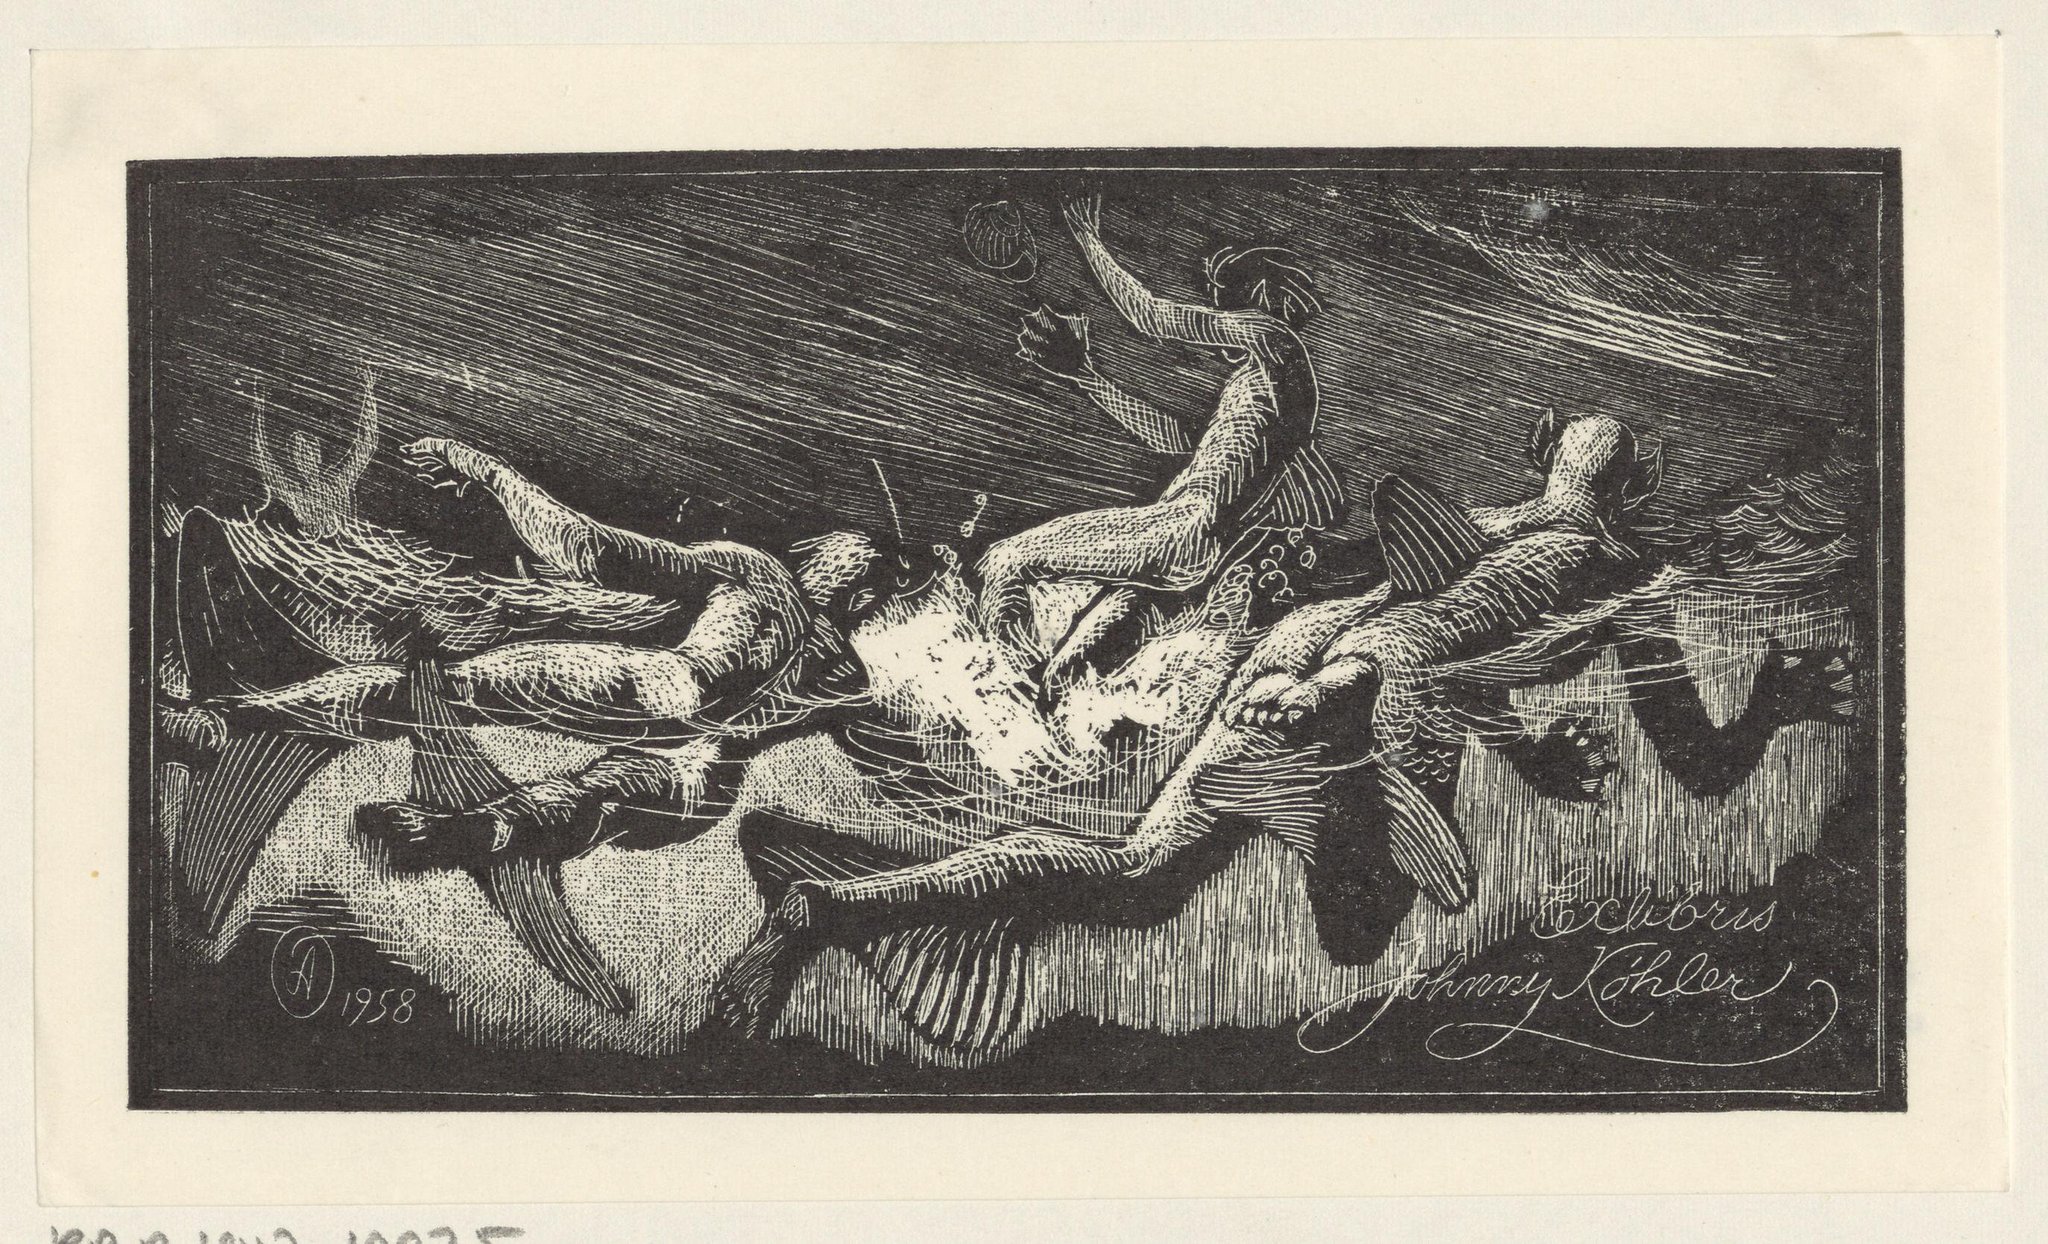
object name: bookplate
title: Ex libris van Johnny Køhler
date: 1958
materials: paper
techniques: printing block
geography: denmark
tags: fishes, swimming (movement in water), man (showing himself) undressed, quasi-nude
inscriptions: workshop stamp: ‘Thomas Arnel - Denmark - 1958’, workshop stamp: ‘Etching in zinc-/ original graphic’